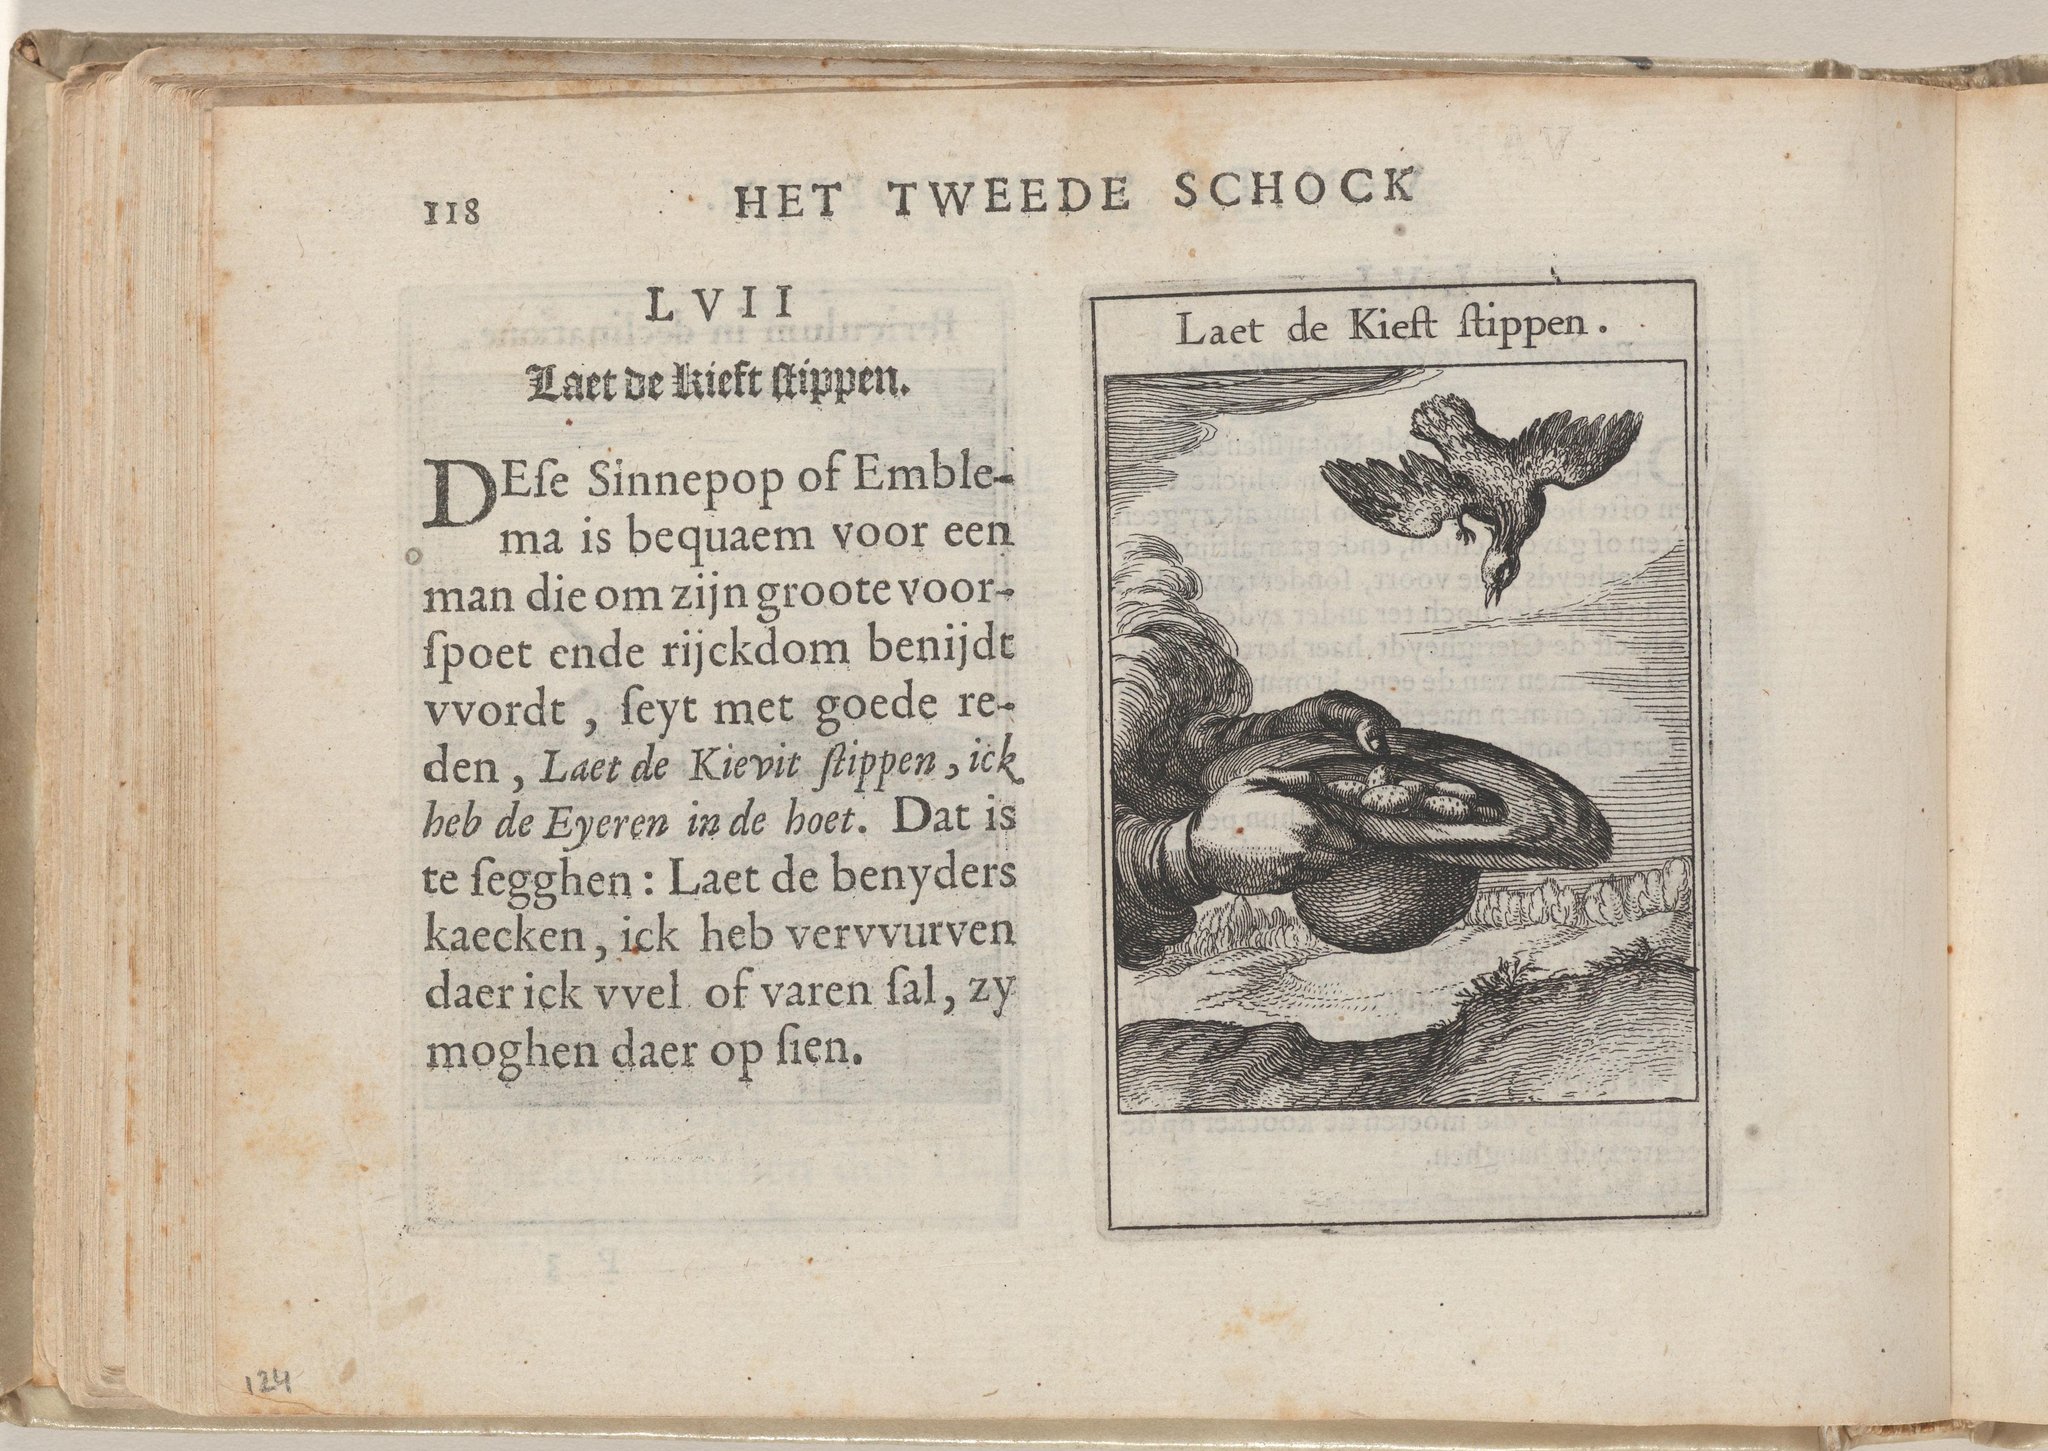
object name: album leaf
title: LVII Laet de Kieft stippen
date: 1614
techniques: engraving, printing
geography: amsterdam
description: LVII Laet de Kieft stippen. Tweede schok. Onderdeel van 'Sinnepoppen', R. Visscher, 1614.